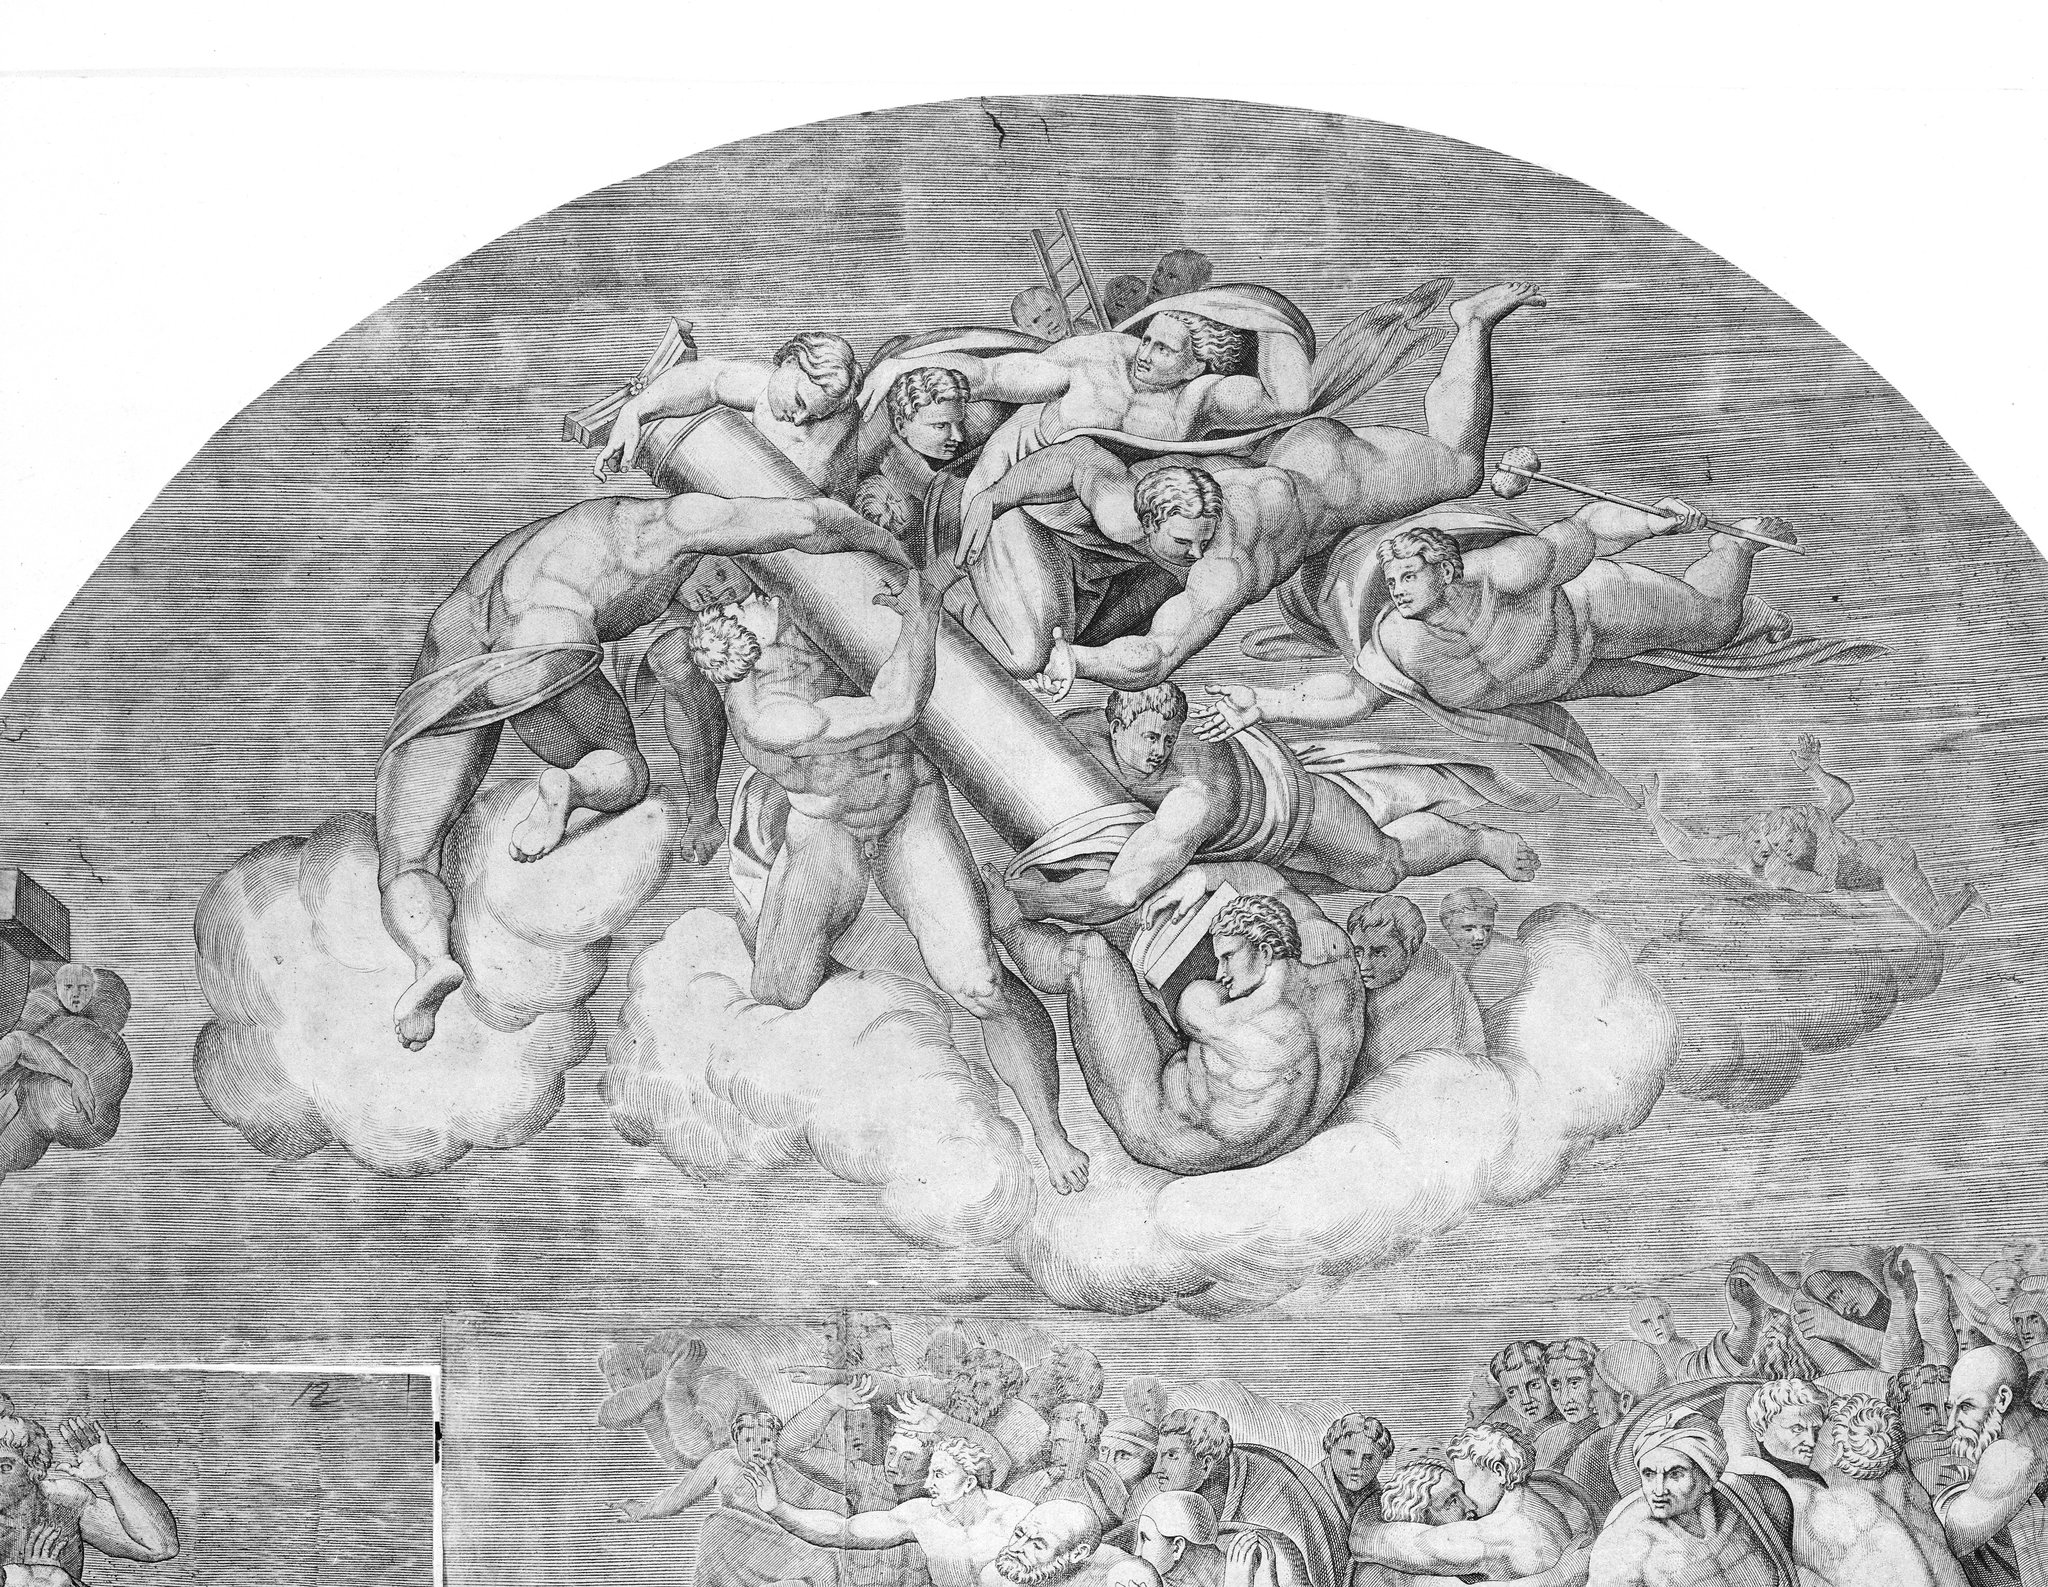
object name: print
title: Angels Carrying Pillar with Saints Below (upper right section of the Last Judgment)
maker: niccolò della casa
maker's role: artist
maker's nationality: french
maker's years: 1543-1548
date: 1548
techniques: engraving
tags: columns,clouds,angels,saints